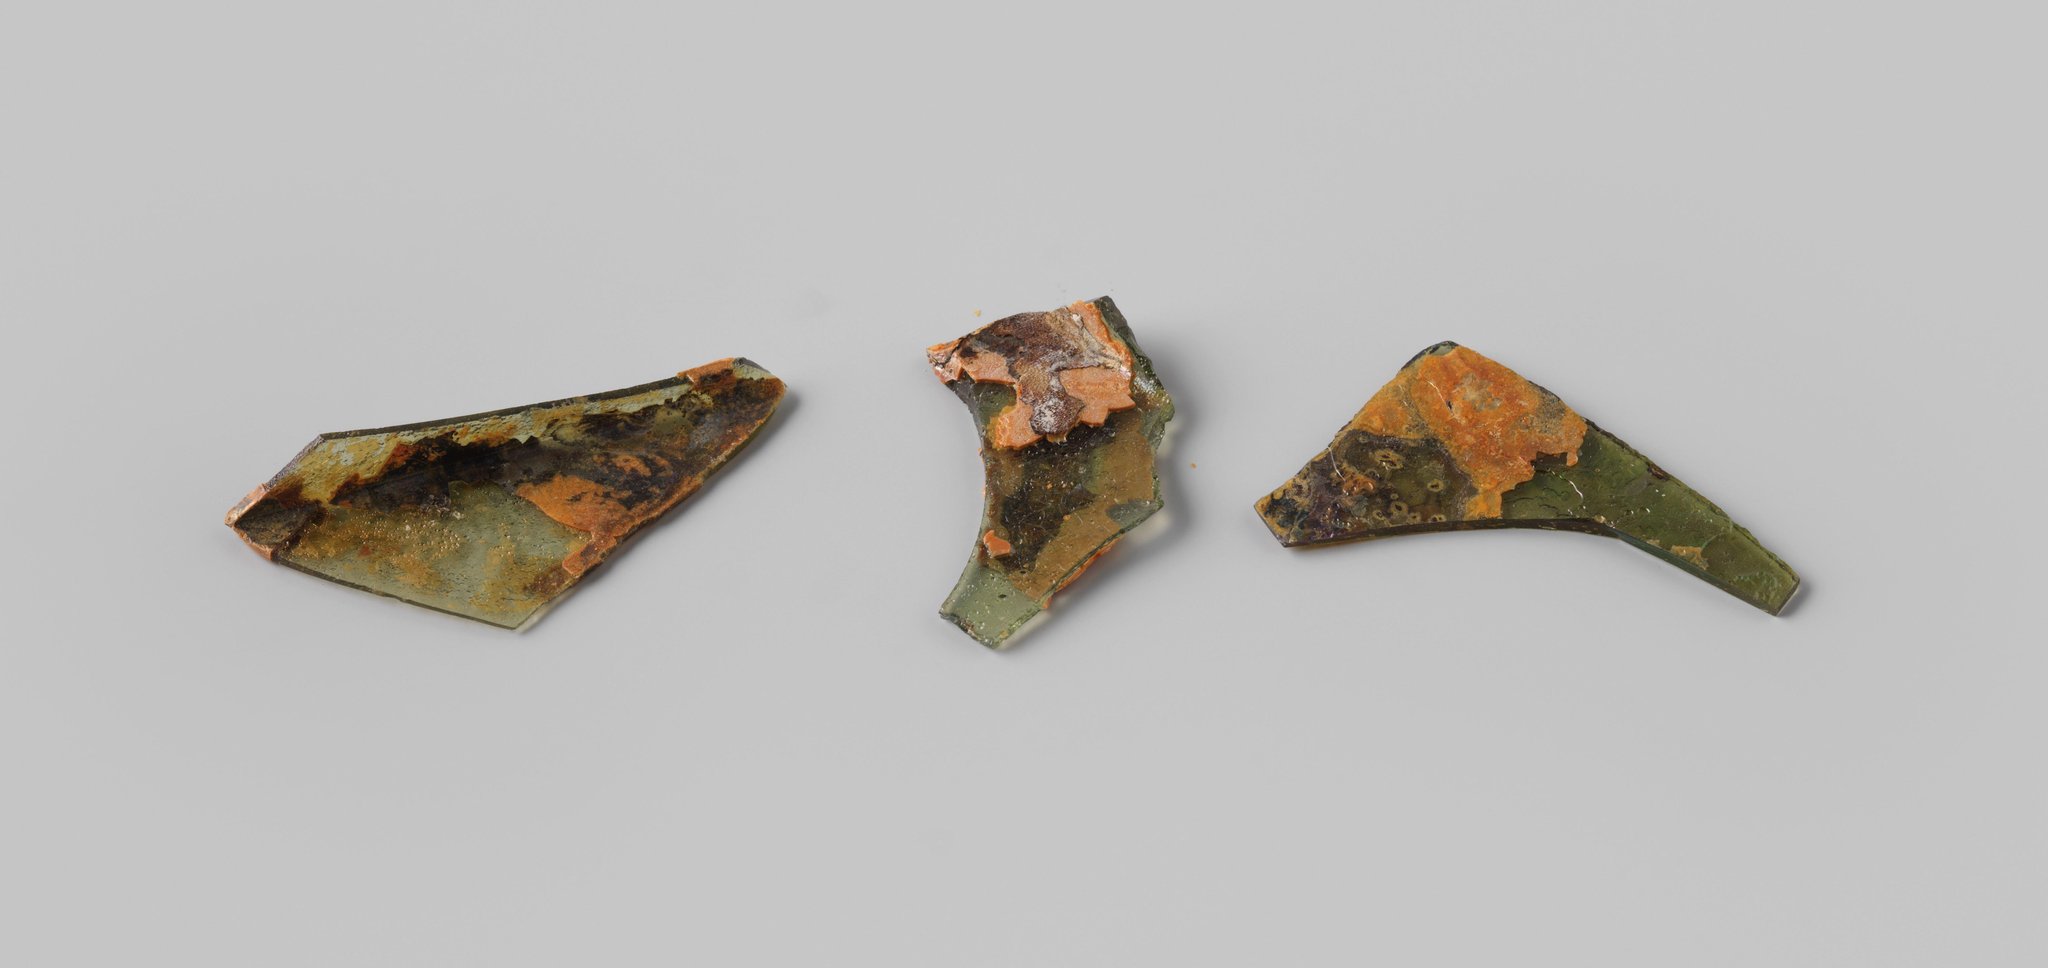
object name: case bottle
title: Scherven van kelderflessen uit het wrak van de Oost-Indiëvaarder 't Vliegend Hart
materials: glass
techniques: green glass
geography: middelburg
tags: 't vliegend hart (schip), verenigde oostindische compagnie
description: Drie fragmenten van vierkante kelderflessen. Gemaakt van groen glas met geelbruine aanslag. Case bottle.